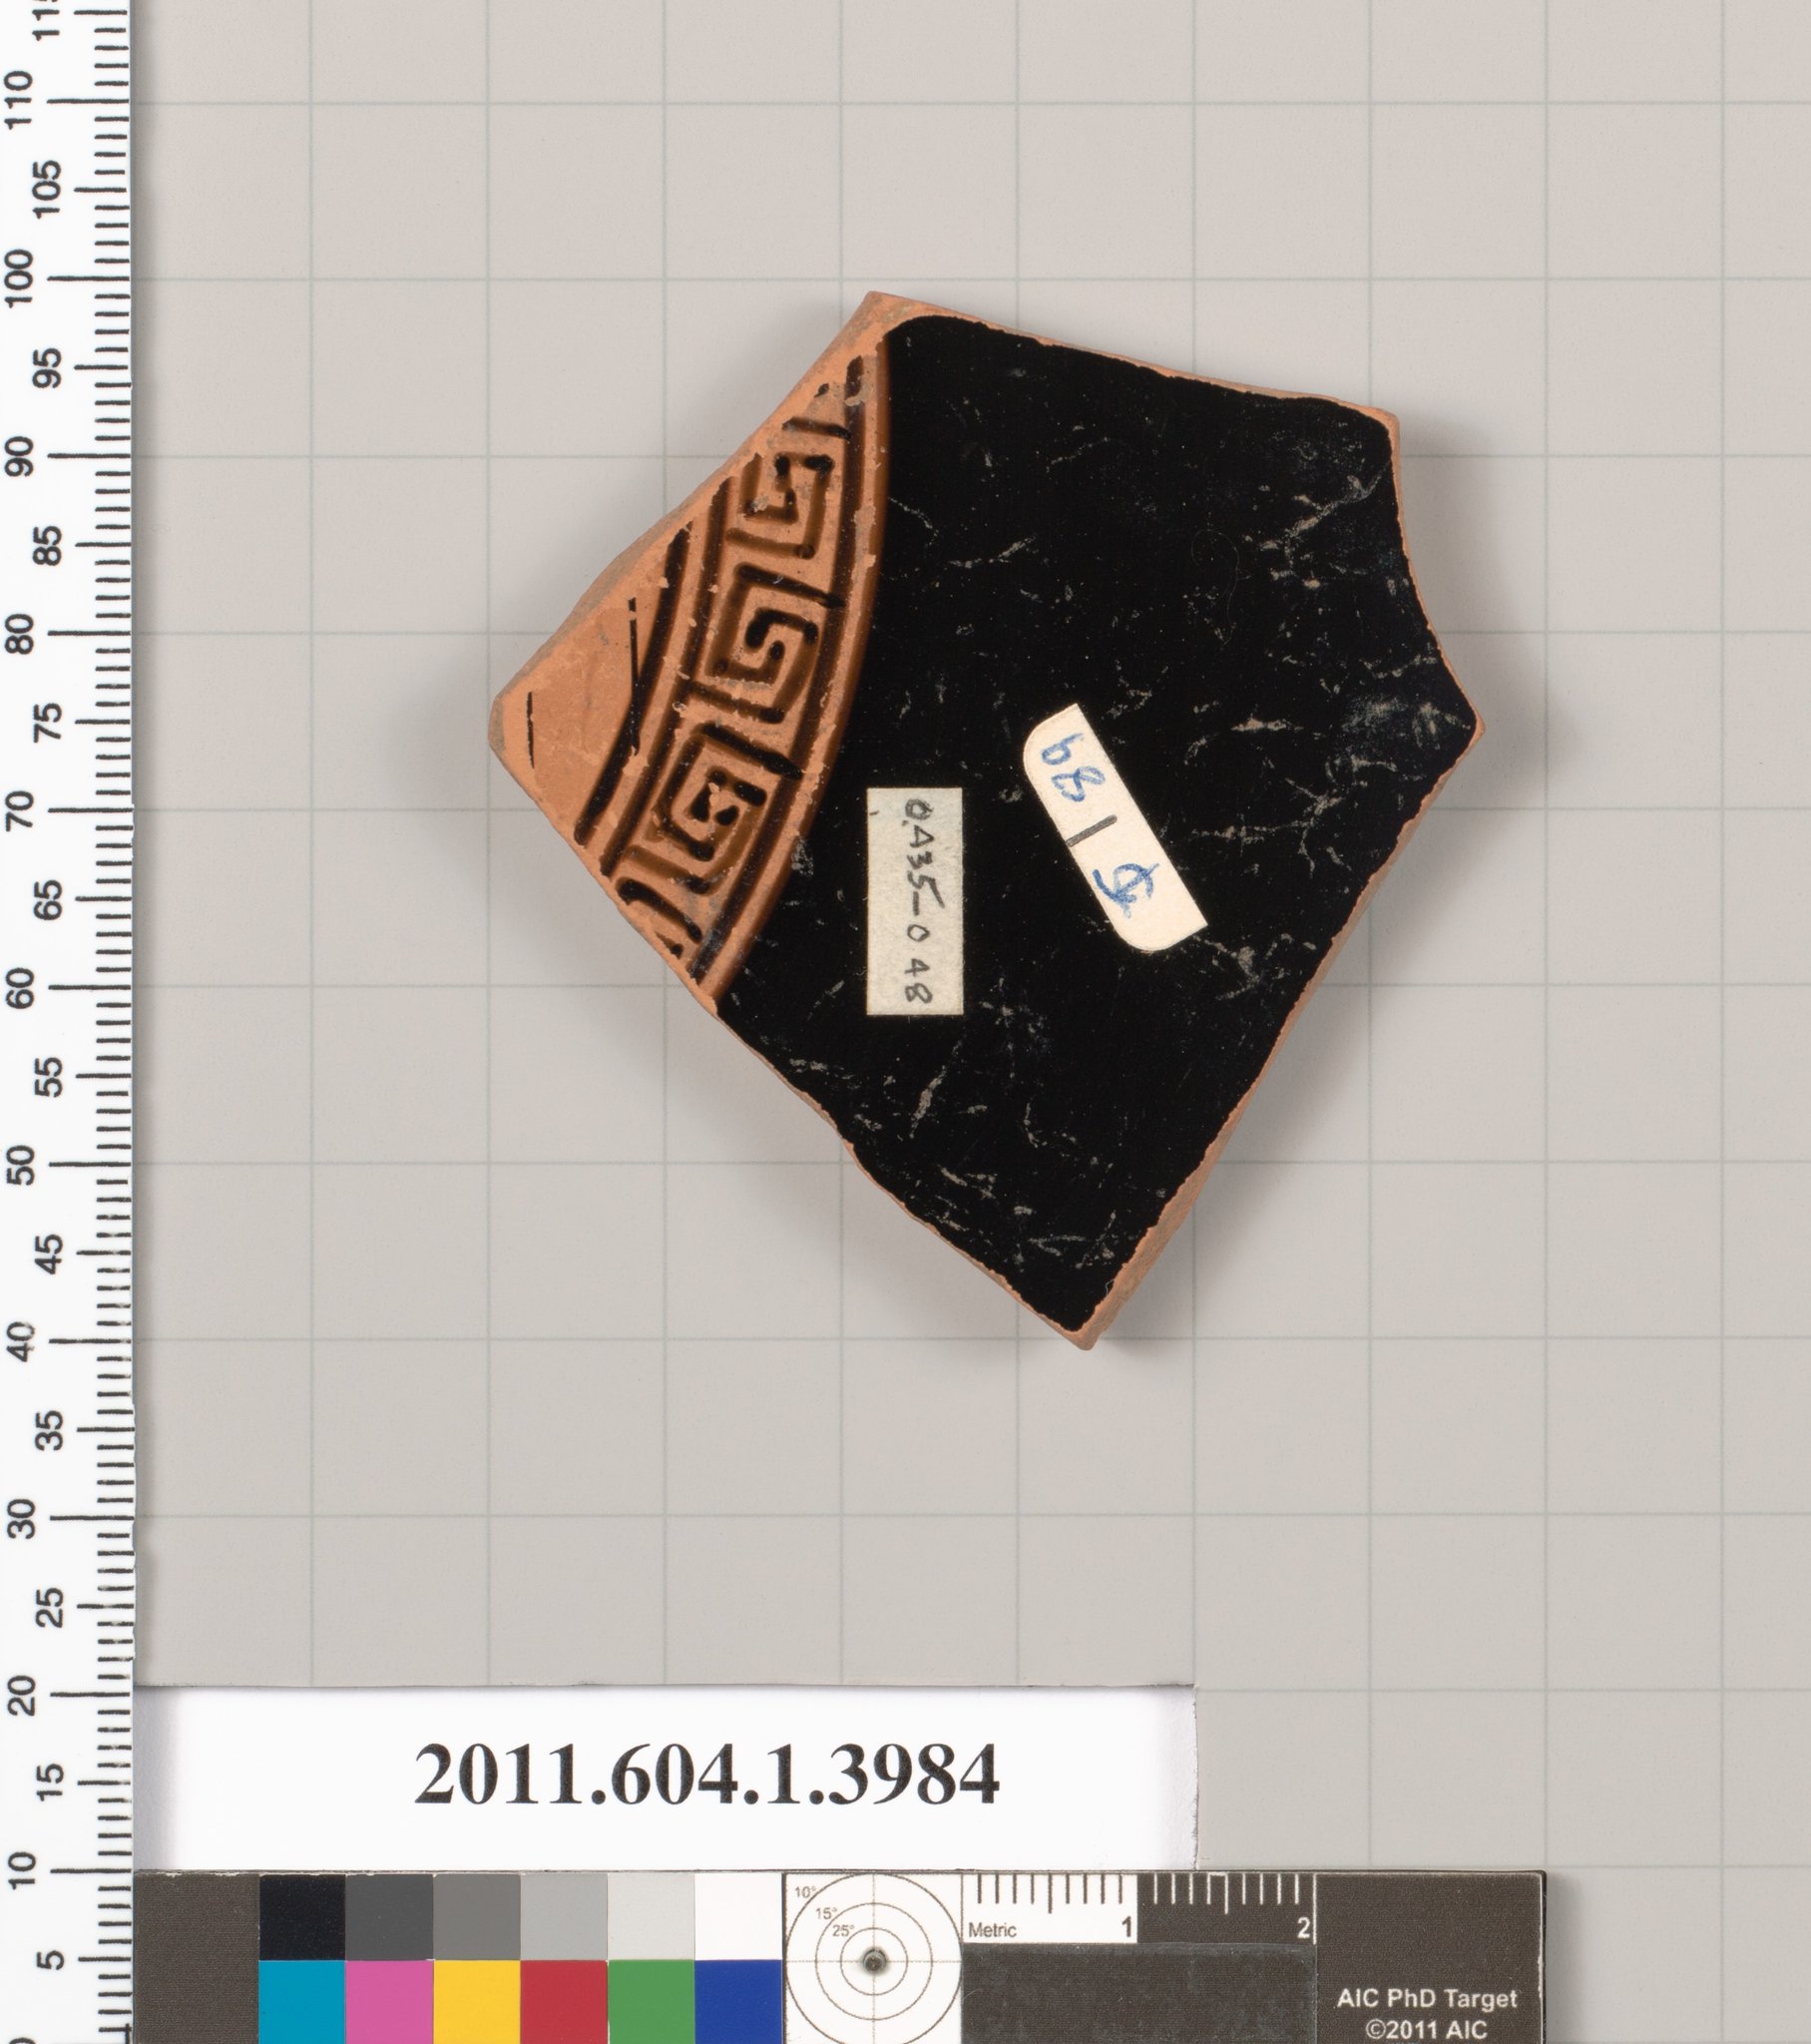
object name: kylix fragment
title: Terracotta fragment of a kylix (drinking cup)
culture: greek, attic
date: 475-451 BCE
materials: terracotta